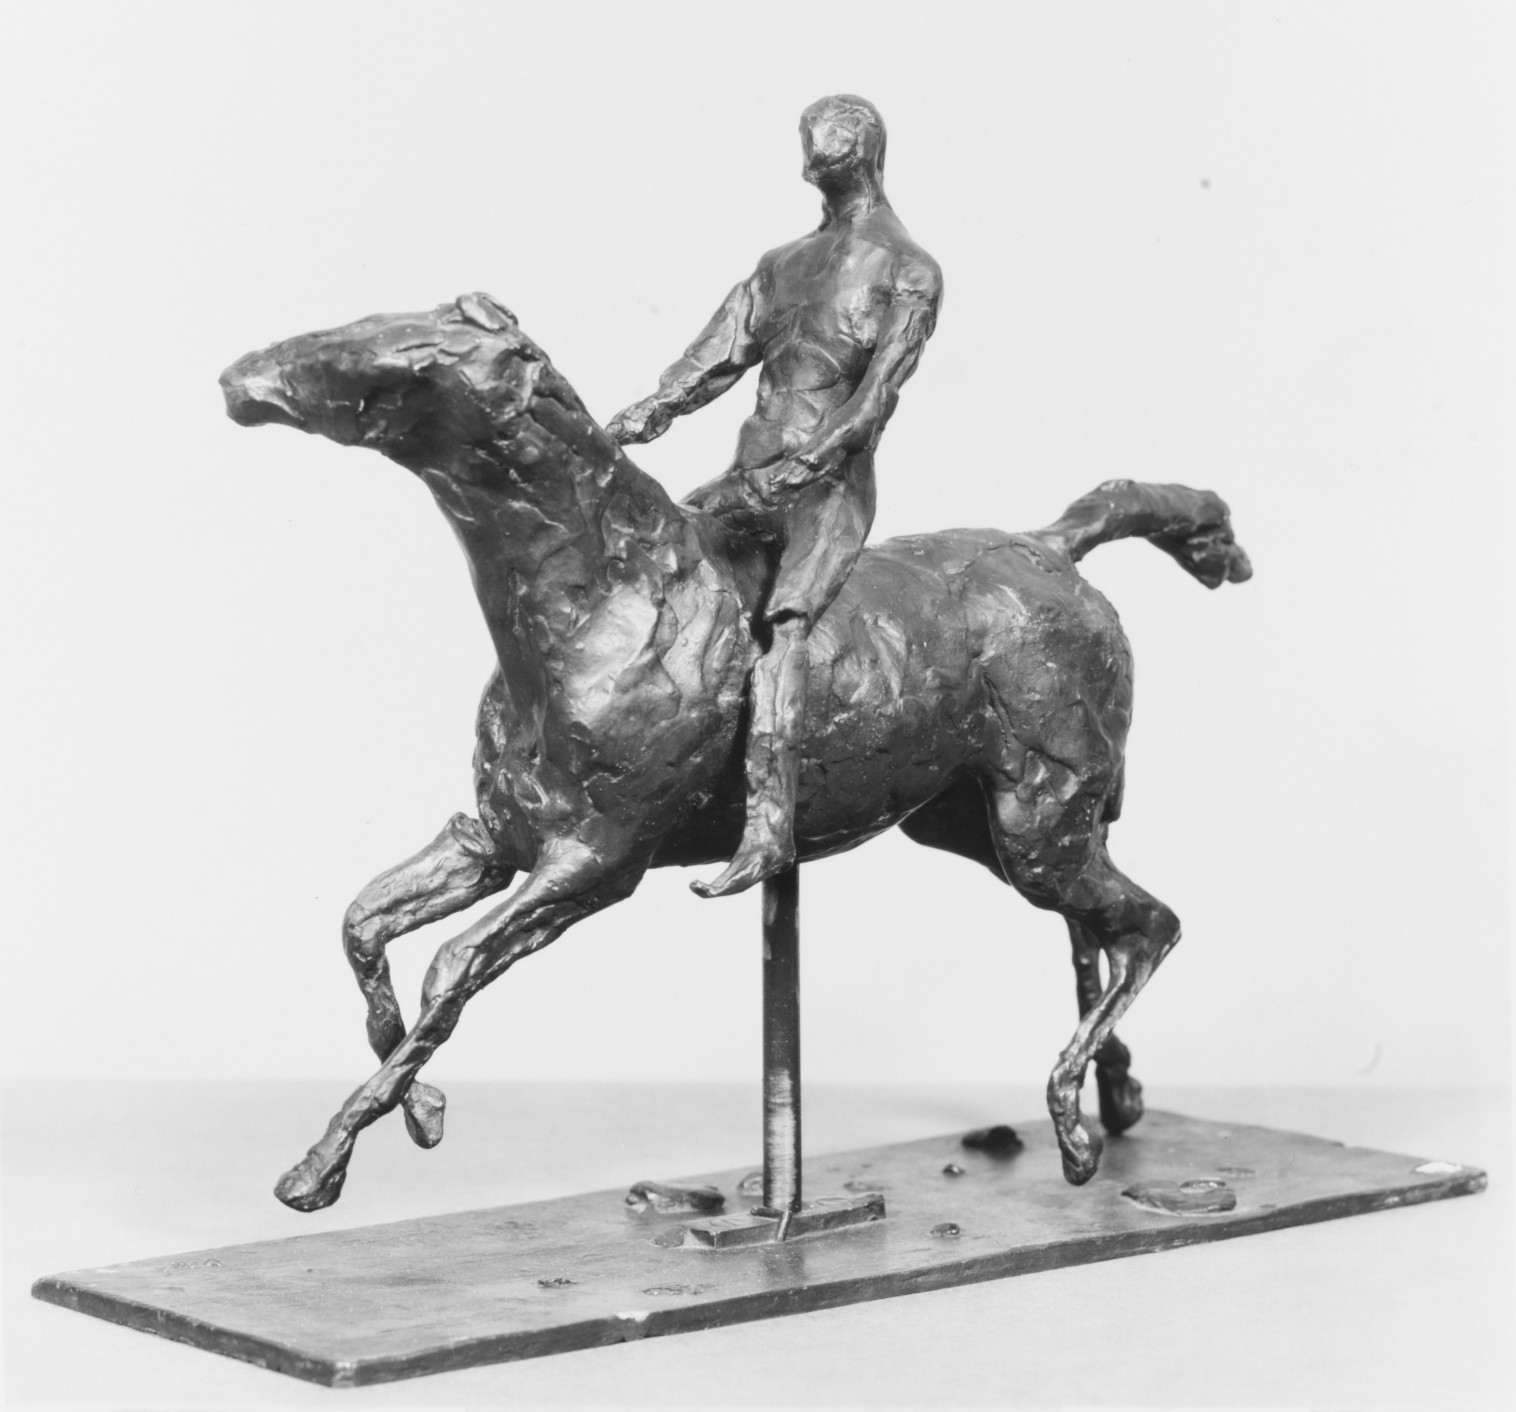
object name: statuette group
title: Horse with Jockey; Horse Galloping, Turning the Head to the Right, the Feet Not Touching the Ground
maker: edgar degas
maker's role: artist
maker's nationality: french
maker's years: 1834-1917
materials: bronze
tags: horses,jockeys